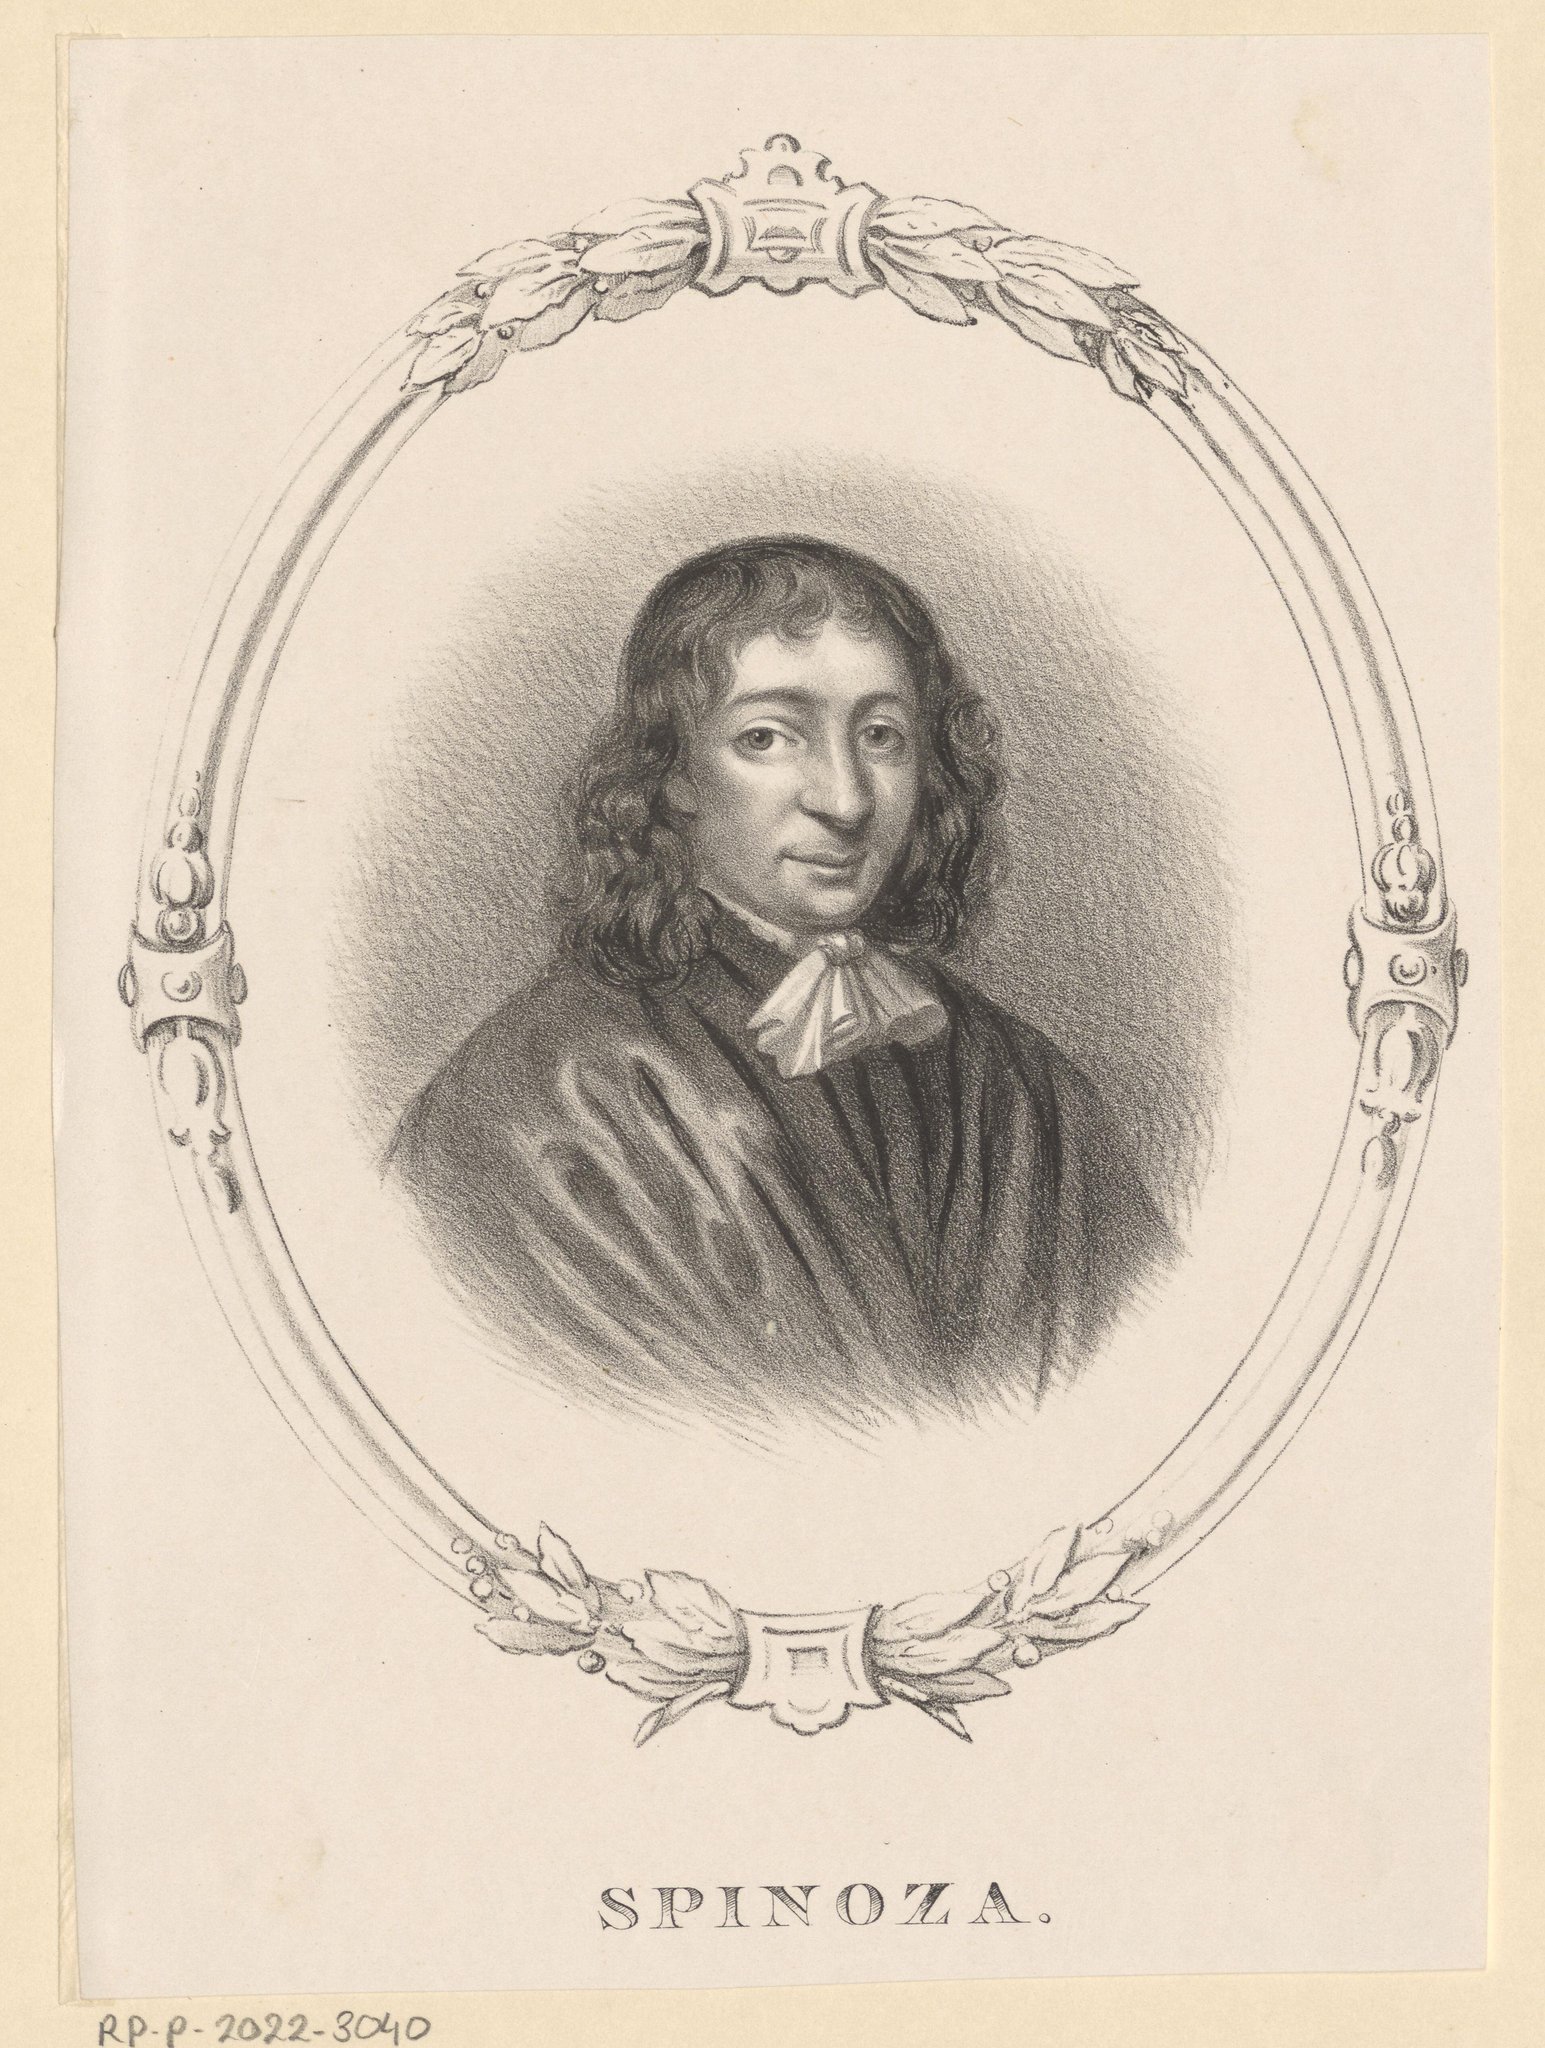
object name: print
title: Portret van Baruch de Spinoza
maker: Anonymous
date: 1798-1899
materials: paper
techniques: lithograph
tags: amsterdam, the hague, baruch de spinoza, historical persons, scholar, philosopher (+ portrait of scholar, scientist)